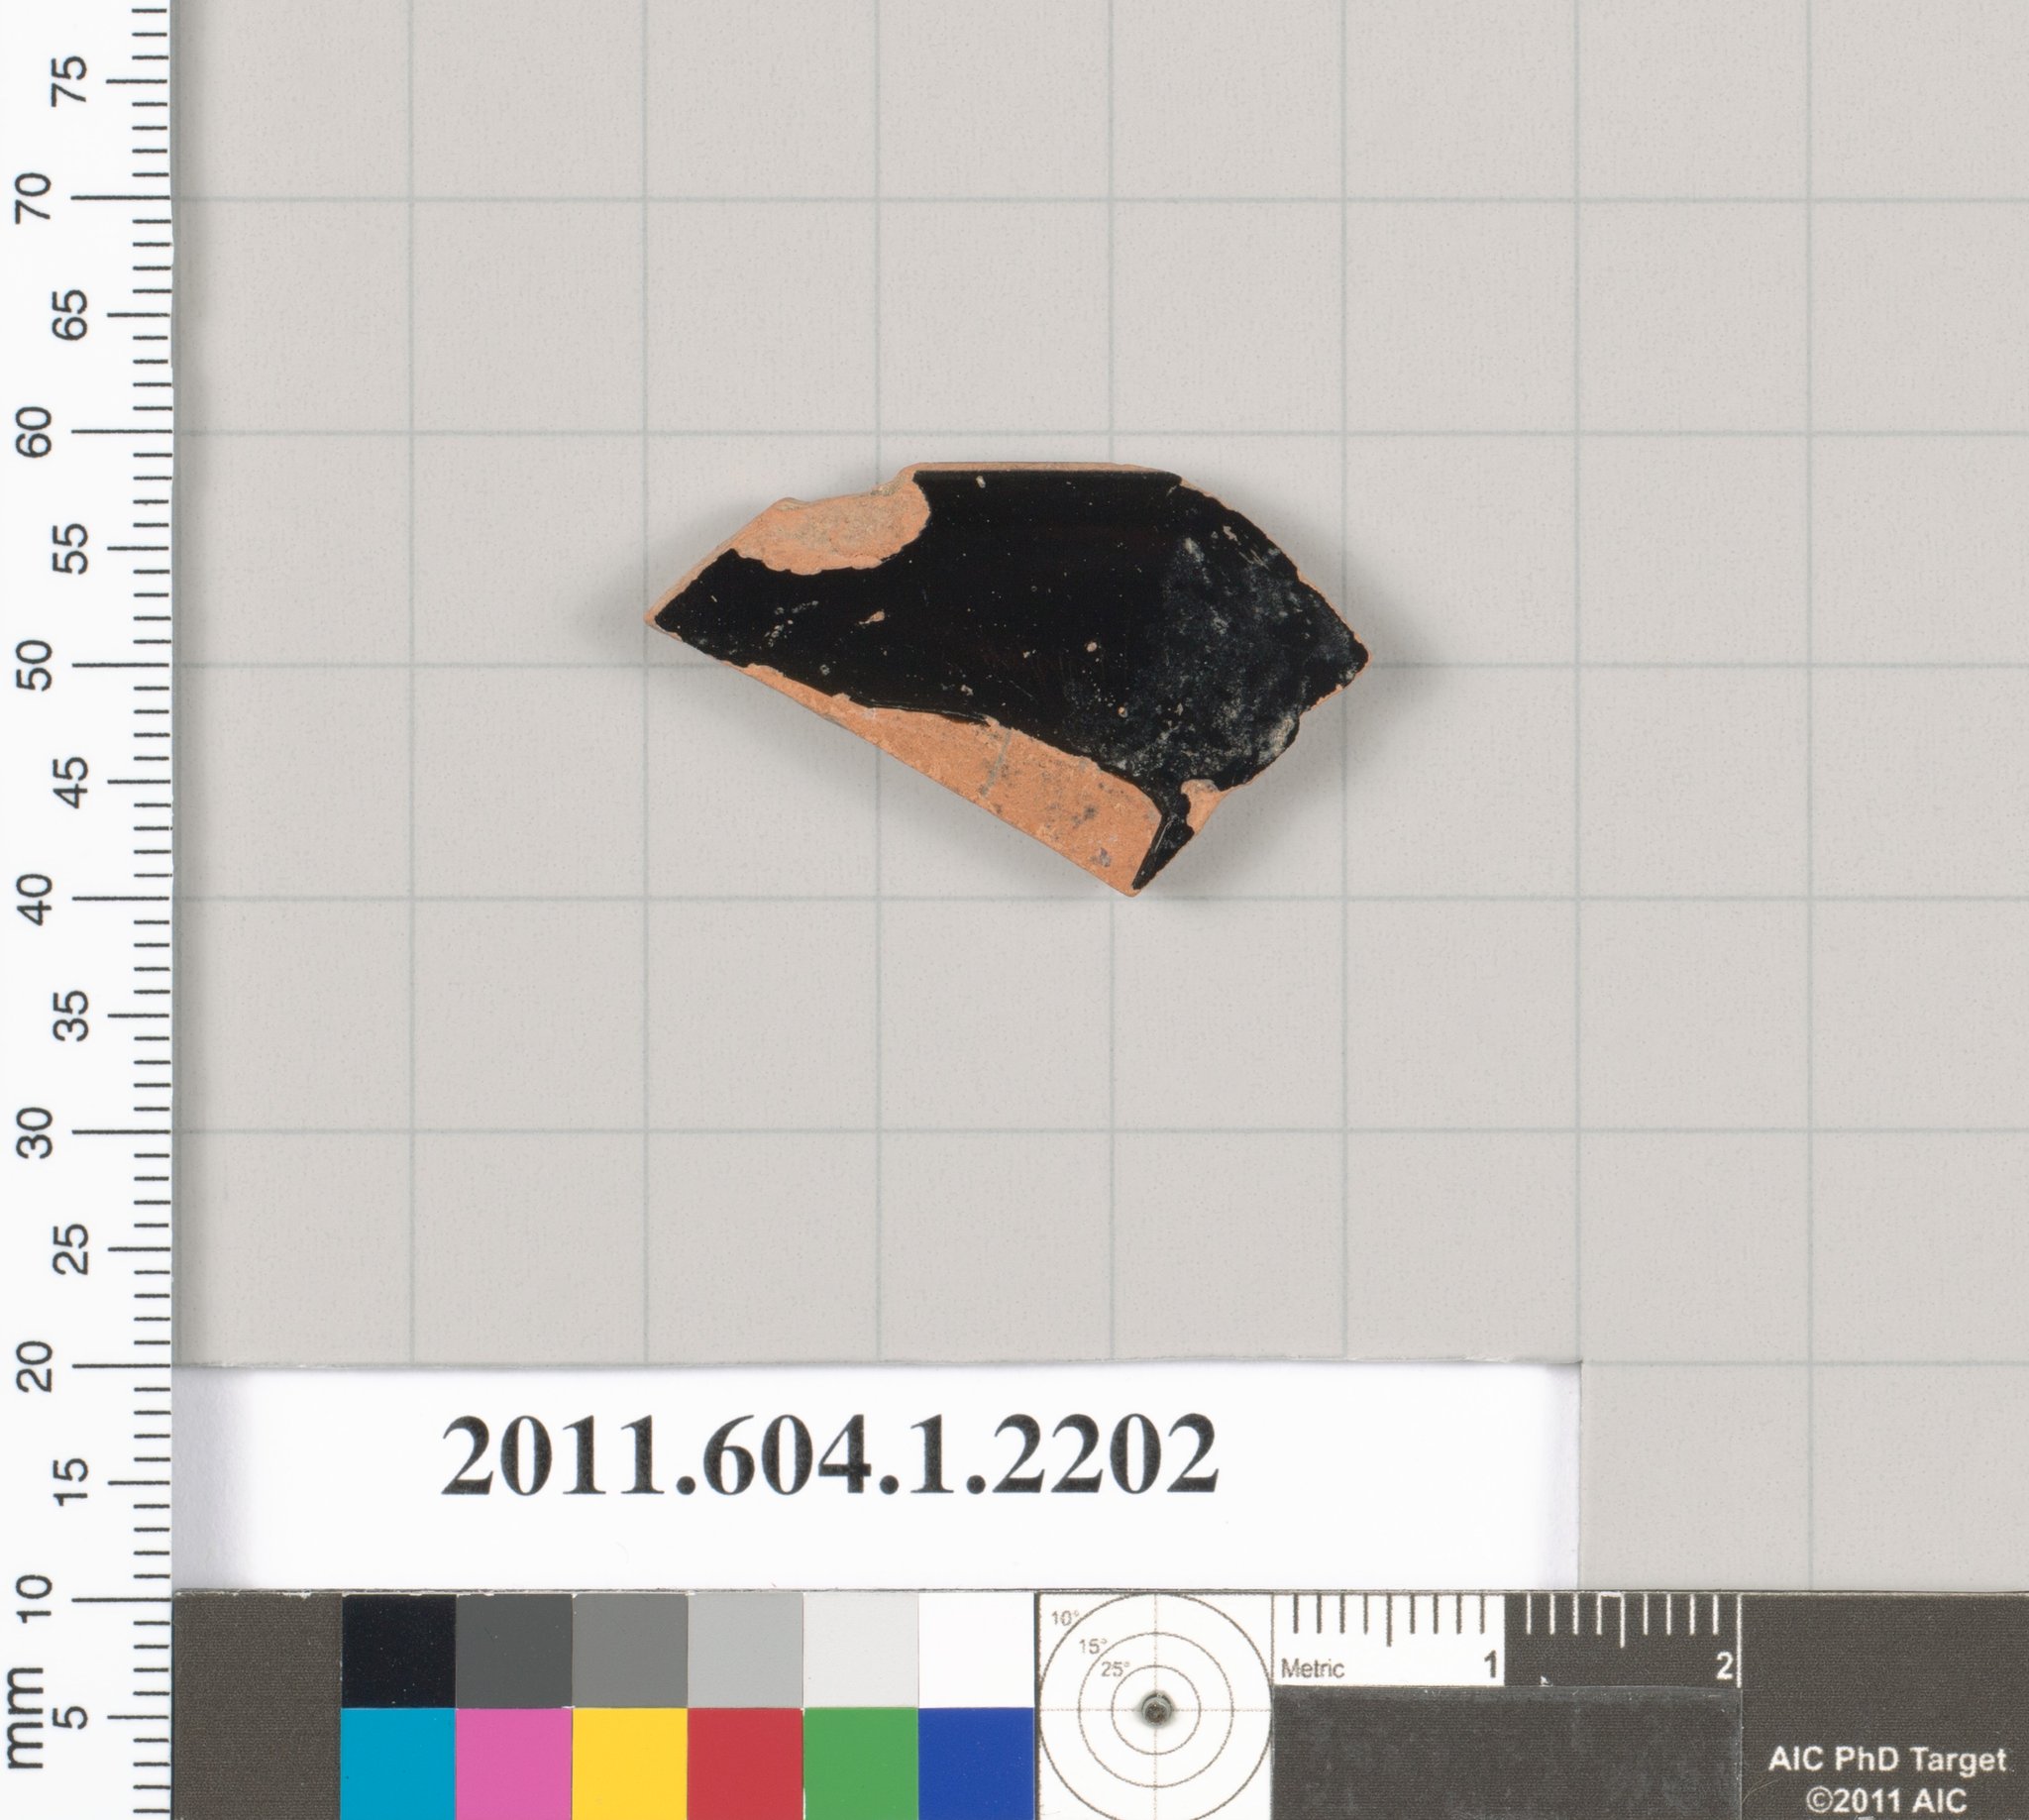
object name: kylix fragment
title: Terracotta rim fragment of a kylix (drinking cup)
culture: greek, attic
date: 475-451 BCE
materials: terracotta